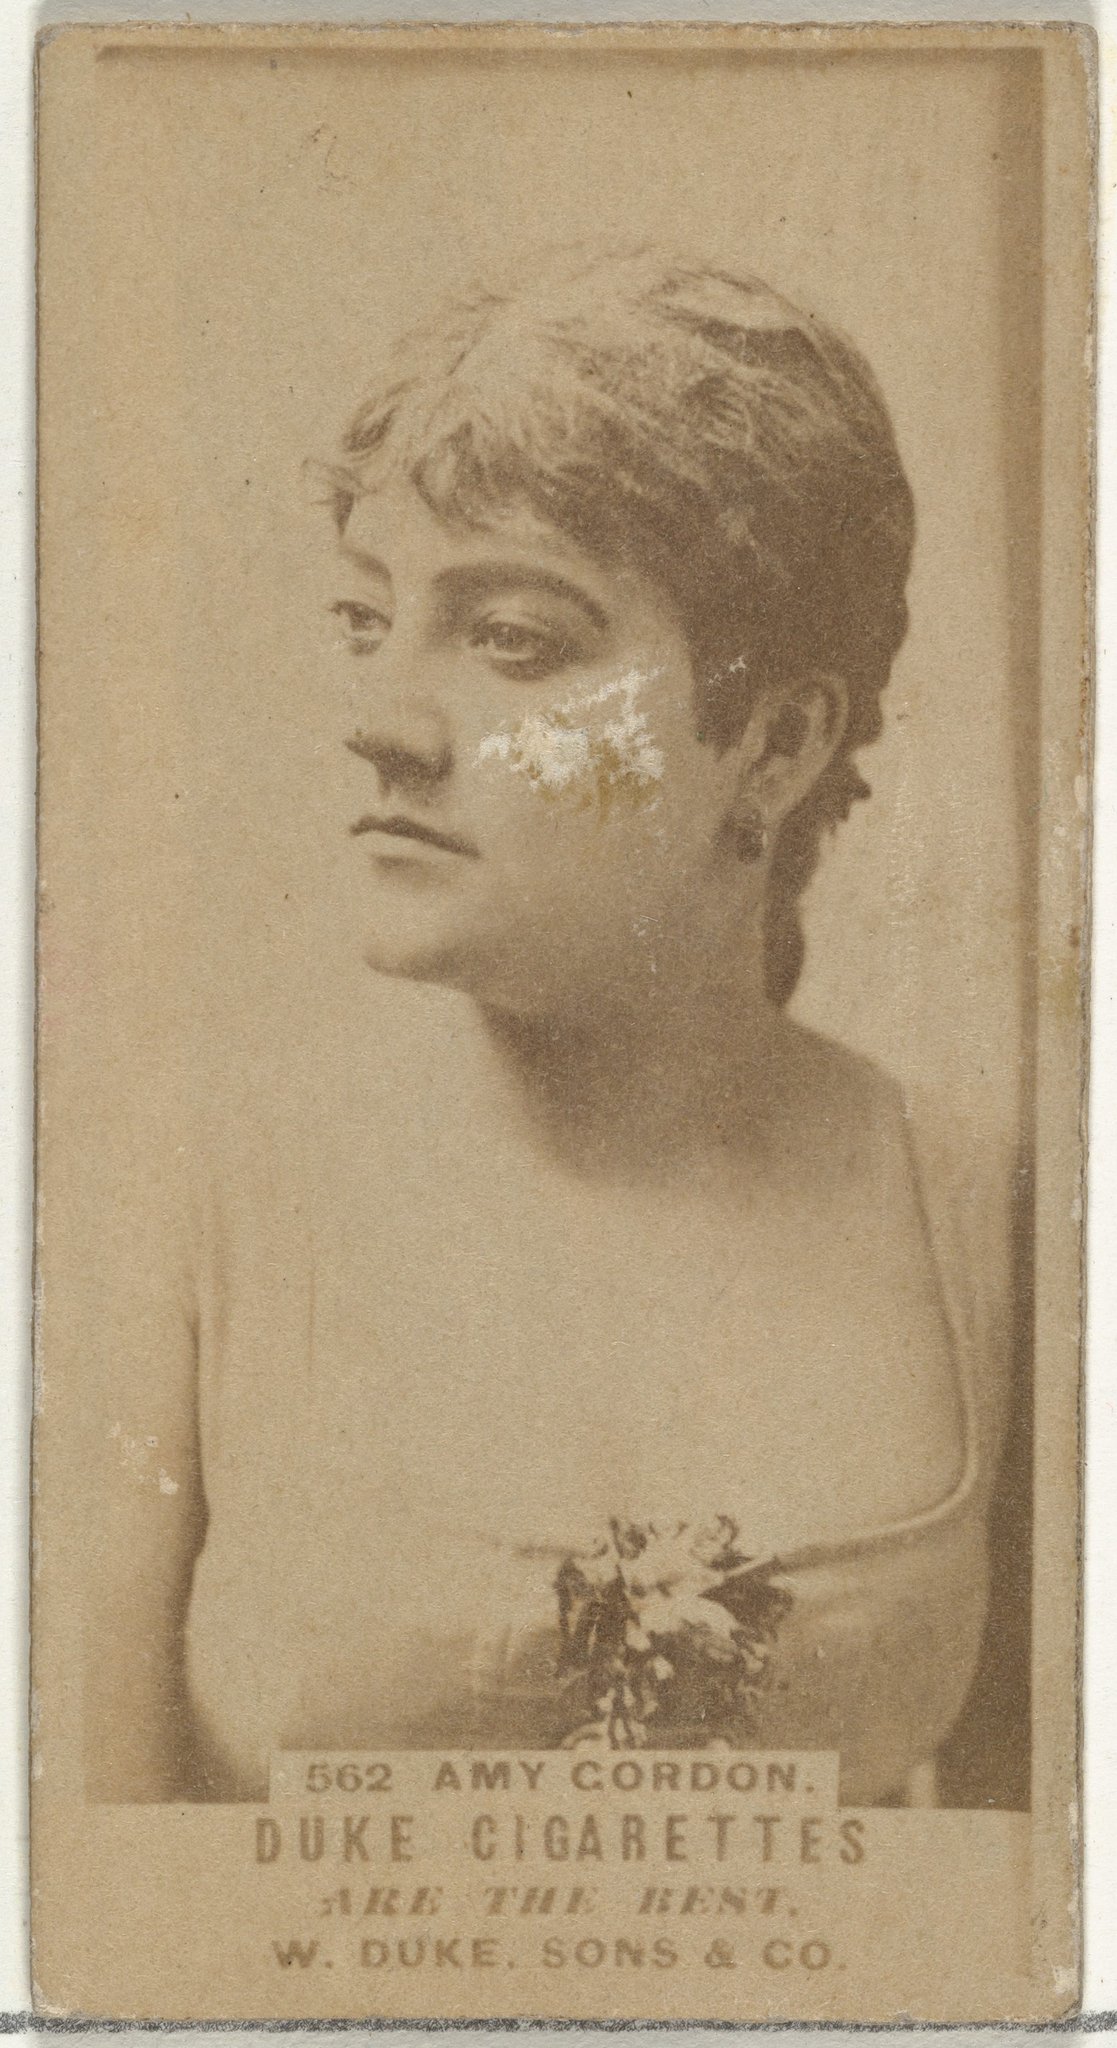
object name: photograph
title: Card Number 562, Amy Gordon, from the Actors and Actresses series (N145-7) issued by Duke Sons & Co. to promote Duke Cigarettes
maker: w. duke, sons & co.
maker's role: publisher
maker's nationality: american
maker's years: 1870-1920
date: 1880-1889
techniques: albumen silver print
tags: portraits,women,actresses